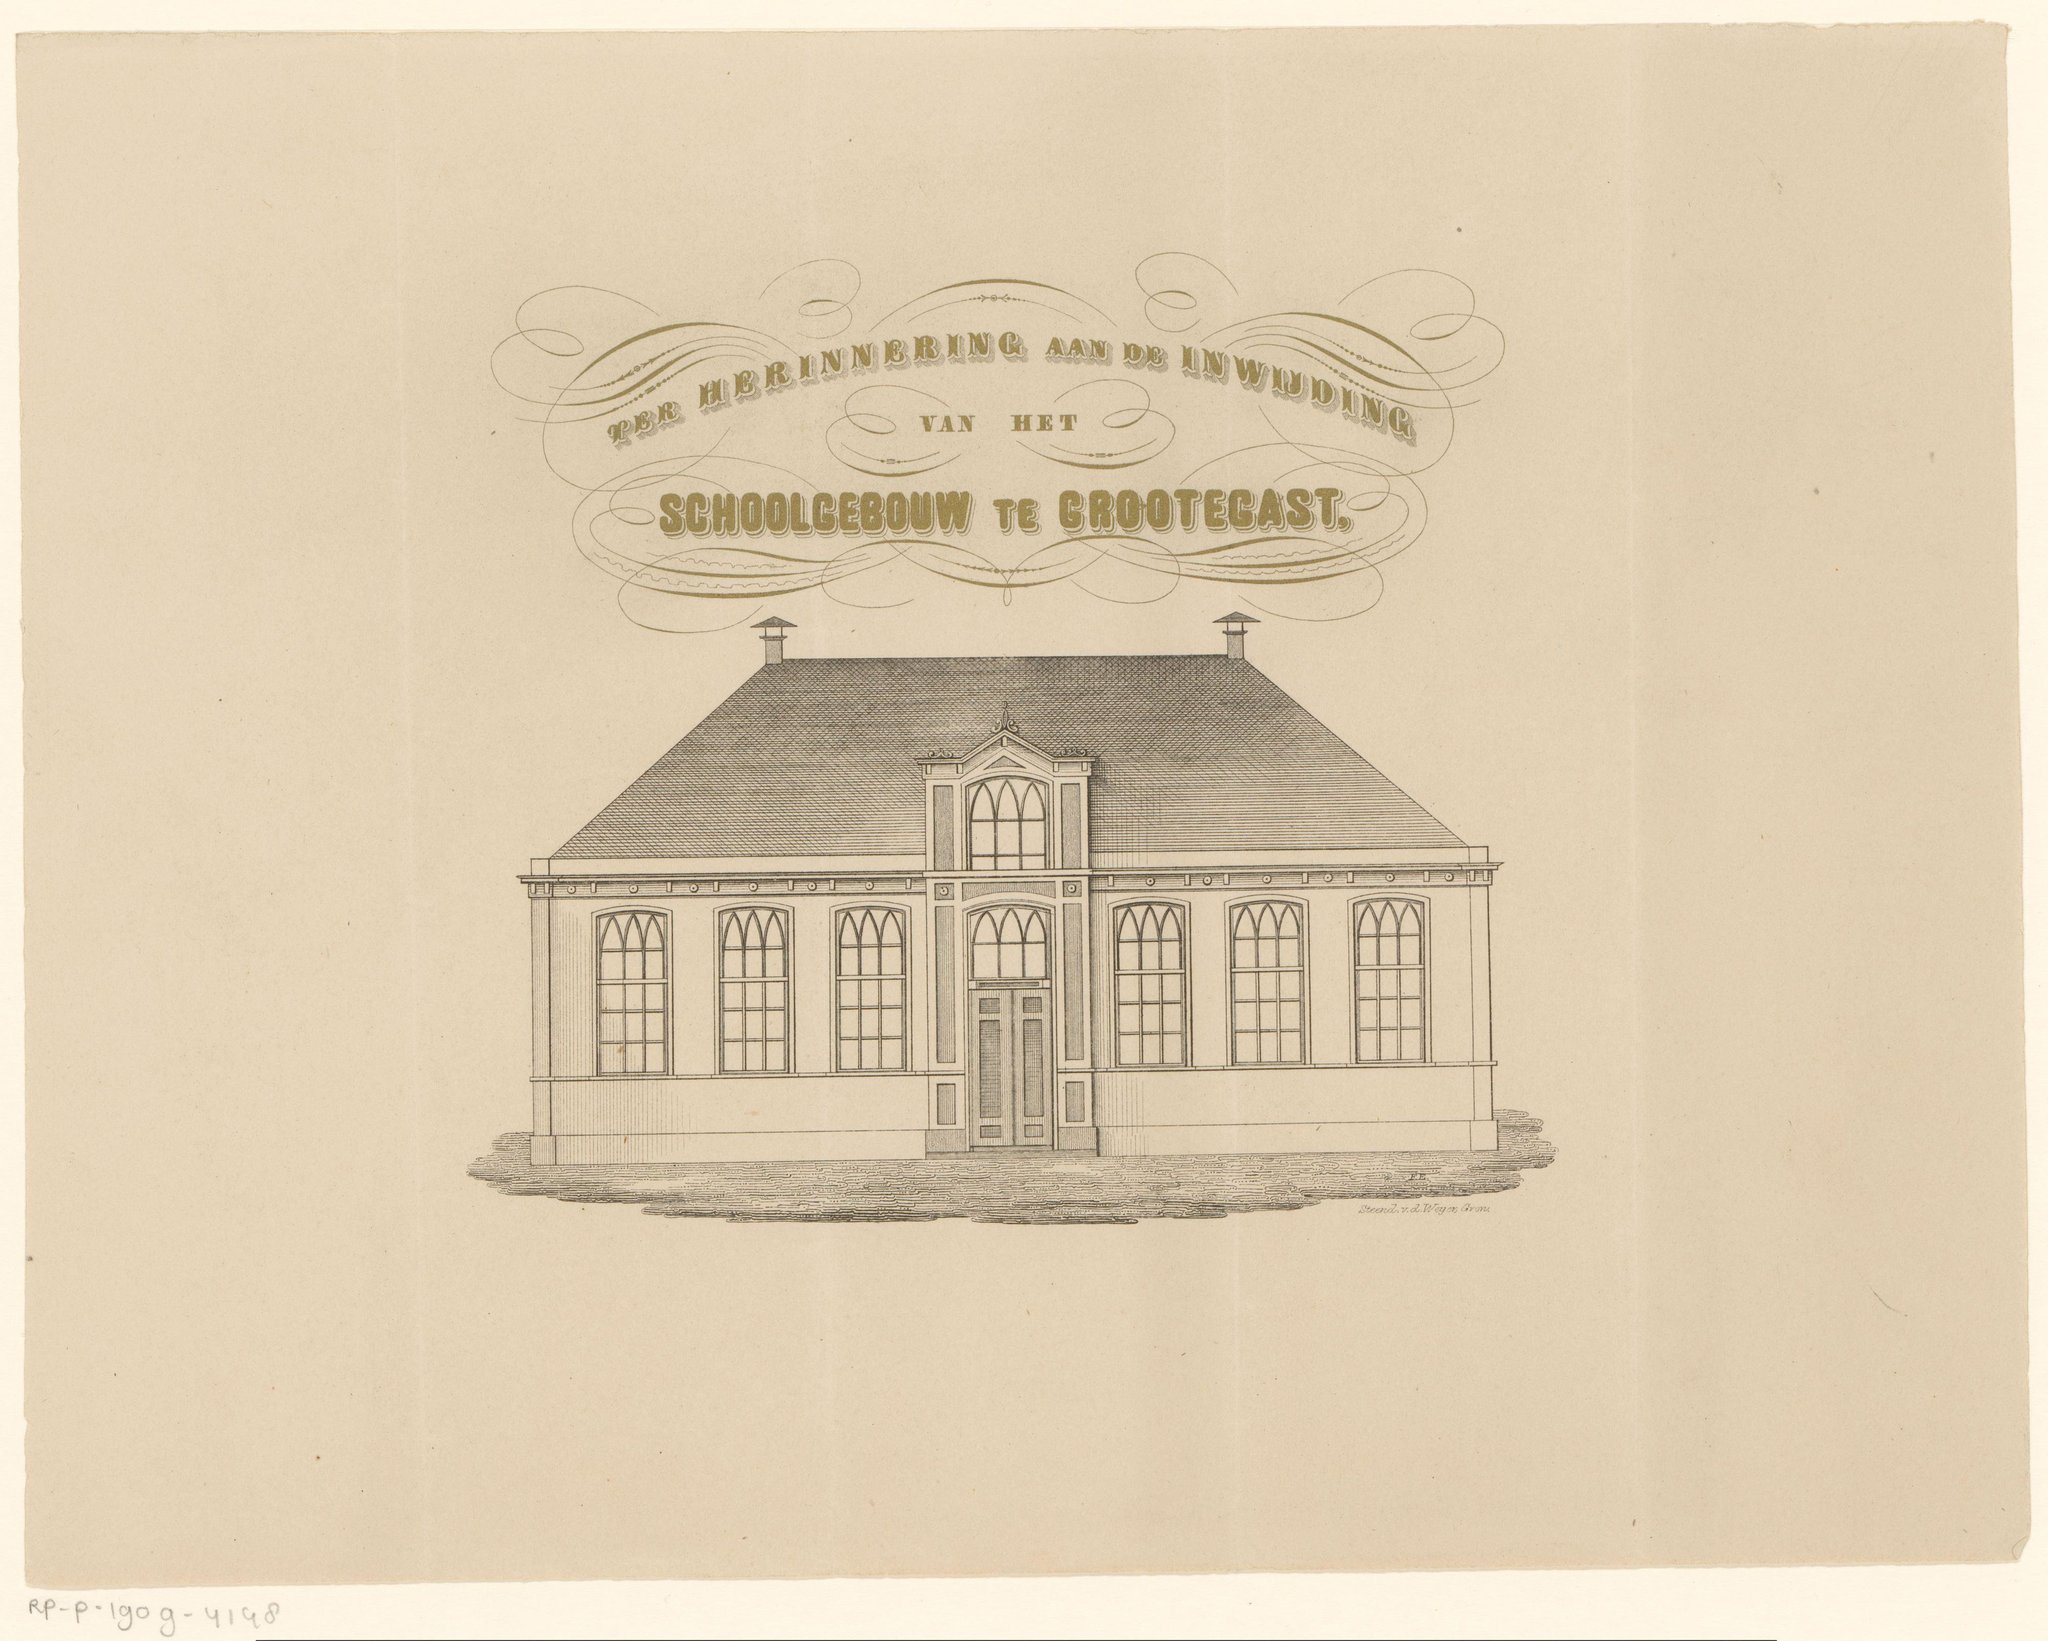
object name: print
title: Schoolgebouw te Grootegast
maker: johannes hermanus van de weijer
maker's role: print maker, printer, publisher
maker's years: 1817-1889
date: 1840-1876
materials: paper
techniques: lithograph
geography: groningen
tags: elementary school; class, form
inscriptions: monogram: ‘FE’, collector's mark: Lugt 2228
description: Afgebeeld is het schoolgebouw met zes ramen en de toegangsdeur.